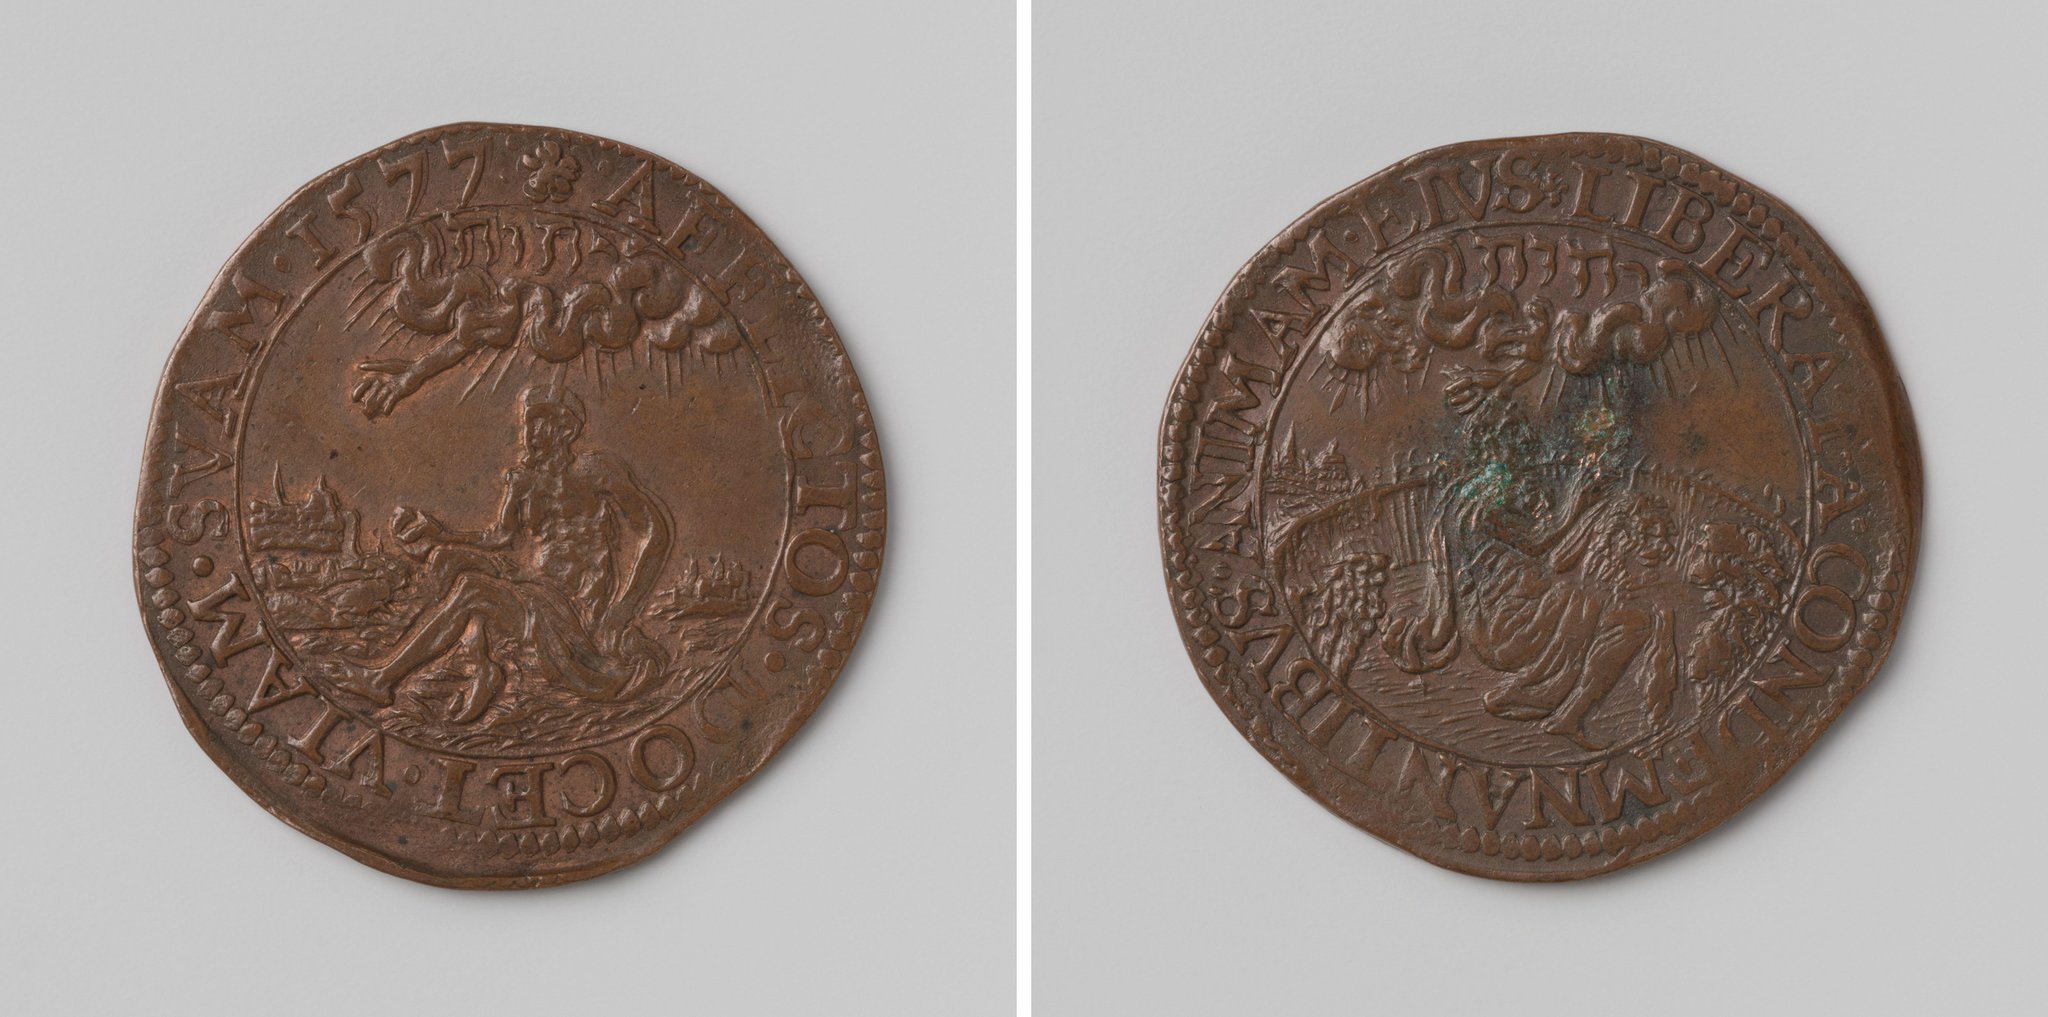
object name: jeton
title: Goddelijke bijstand aan de opstandelingen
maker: Anonymous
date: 1577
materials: copper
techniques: striking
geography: dordrecht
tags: tachtigjarige oorlog